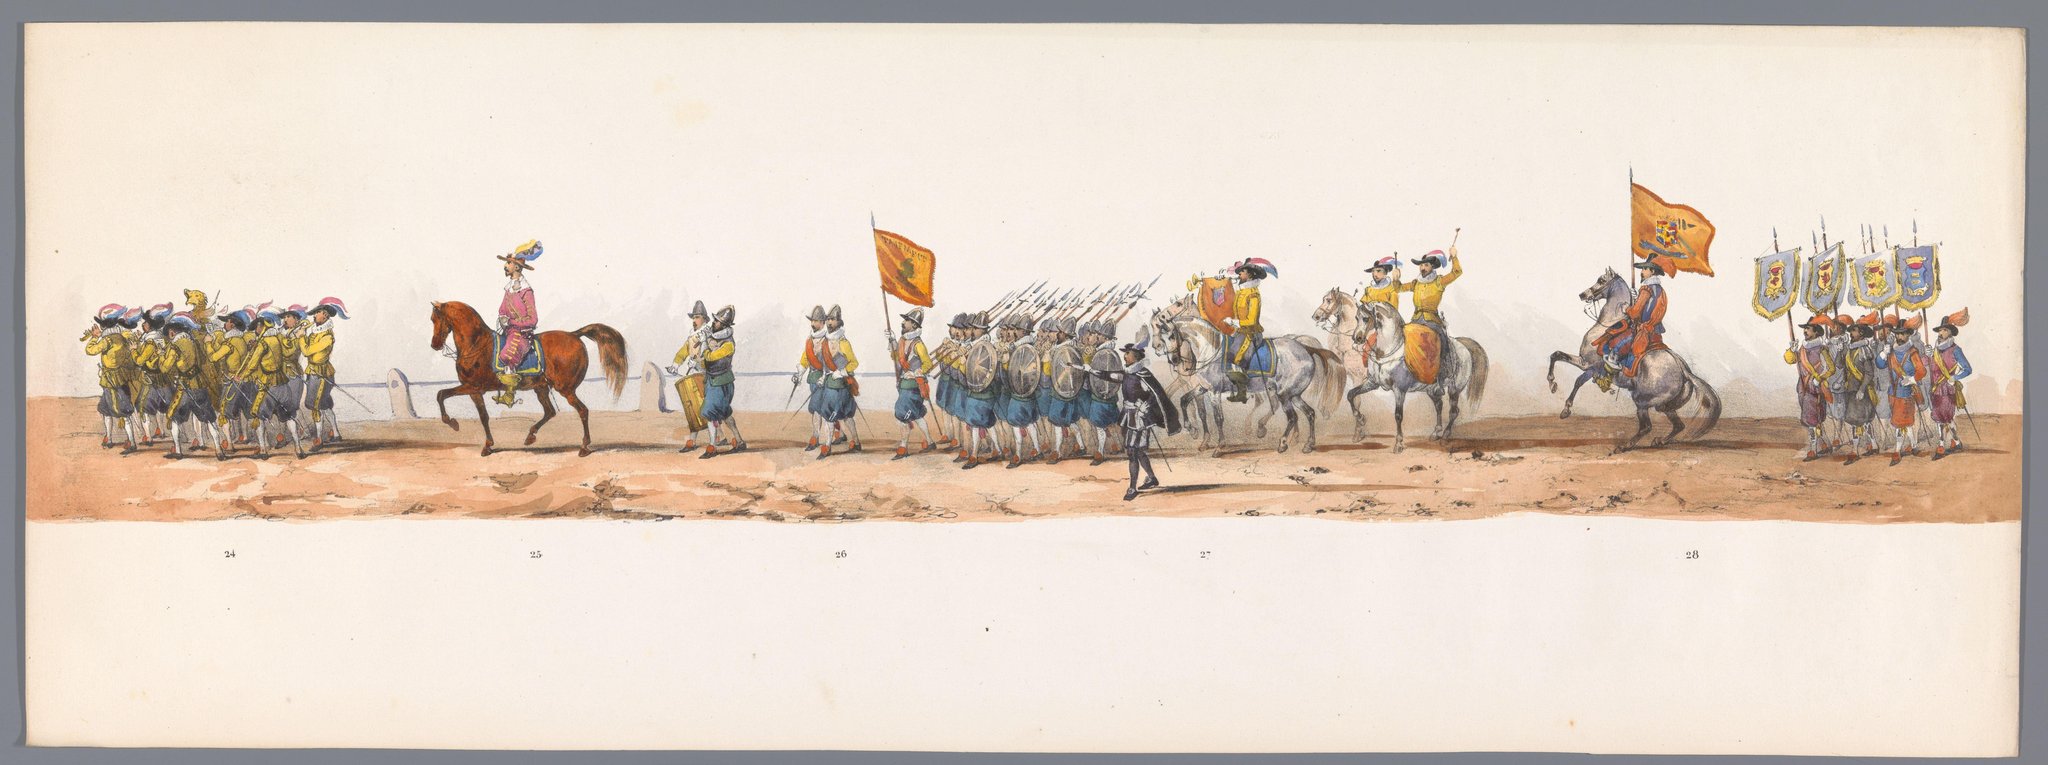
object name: print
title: Historische optocht bij het tweede eeuwfeest van de Utrechtse Hogeschool, 1836 (plaat 7)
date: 1837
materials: paper, watercolor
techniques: hand coloring, lithograph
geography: utrecht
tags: students' pageant, costumes used in pageants, battle of nieuwpoort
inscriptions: date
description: Historische gekostumeerde optocht van de studenten van de Hogeschool van Utrecht op 16 juni 1836, bij de viering van het tweede eeuwfeest van de Utrechtse Hogeschool. De optocht verbeeldt de intocht van het Staatse leger in Oostende op 3 juli 1600, daags na de overwinning in de Slag bij Nieuwpoort. Zevende plaat in een serie van tien ongenummerde platen, met de groepen genummerd 24-28.